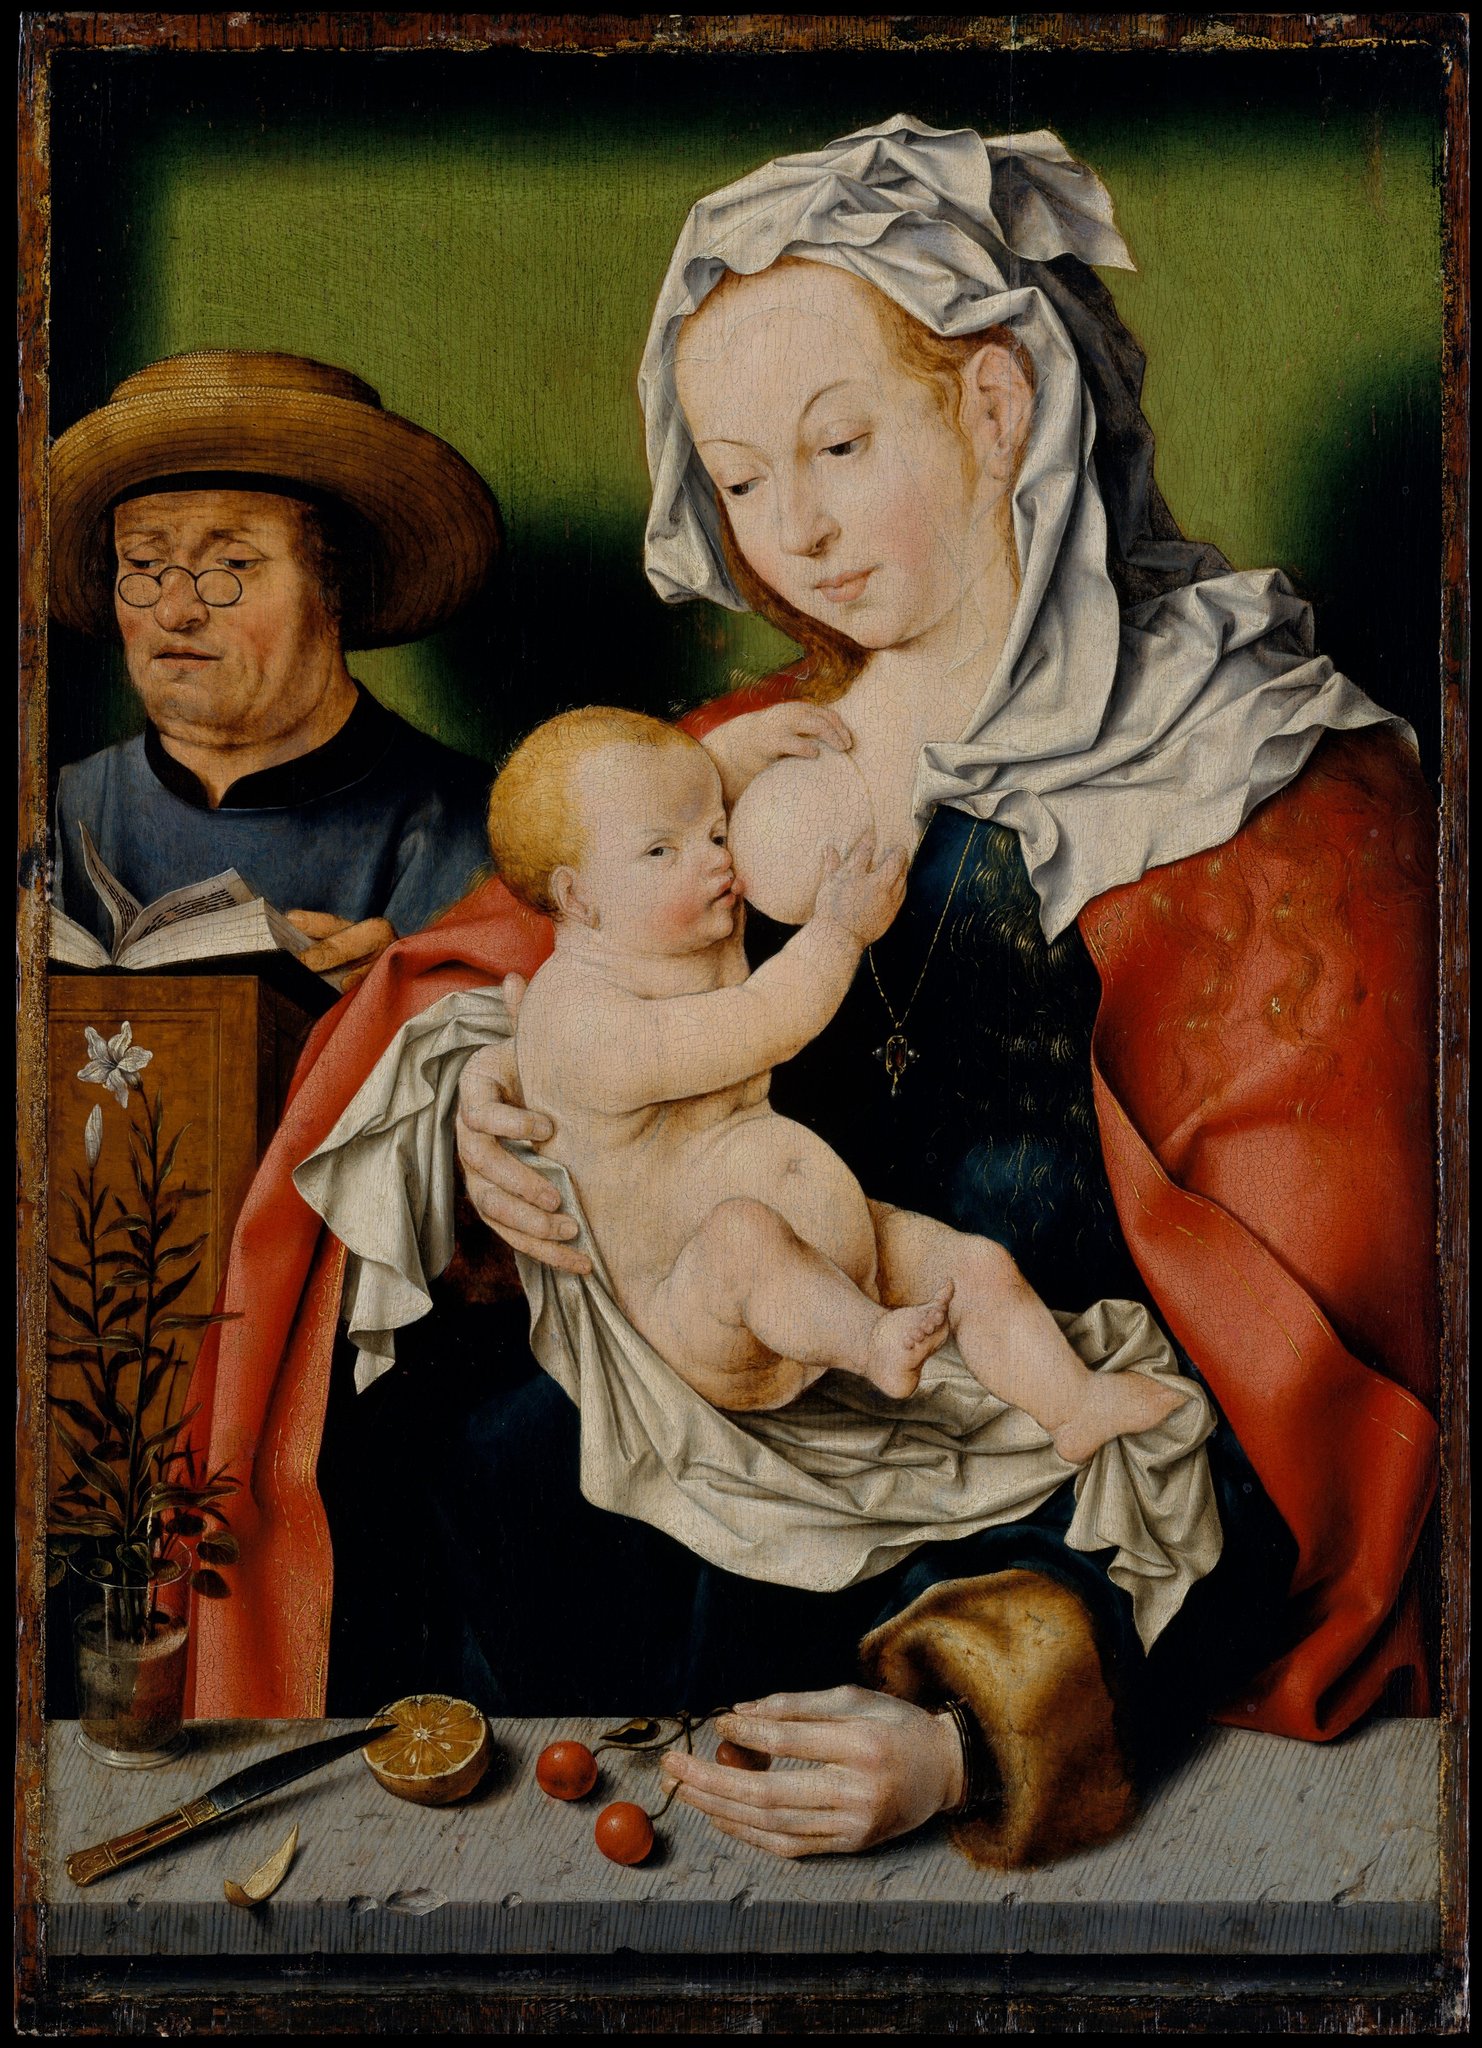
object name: painting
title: The Holy Family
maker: joos van cleve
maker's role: artist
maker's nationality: netherlandish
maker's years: 1485-1541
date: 1525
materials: oil, wood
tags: holy family,virgin mary,jesus,joseph,nursing